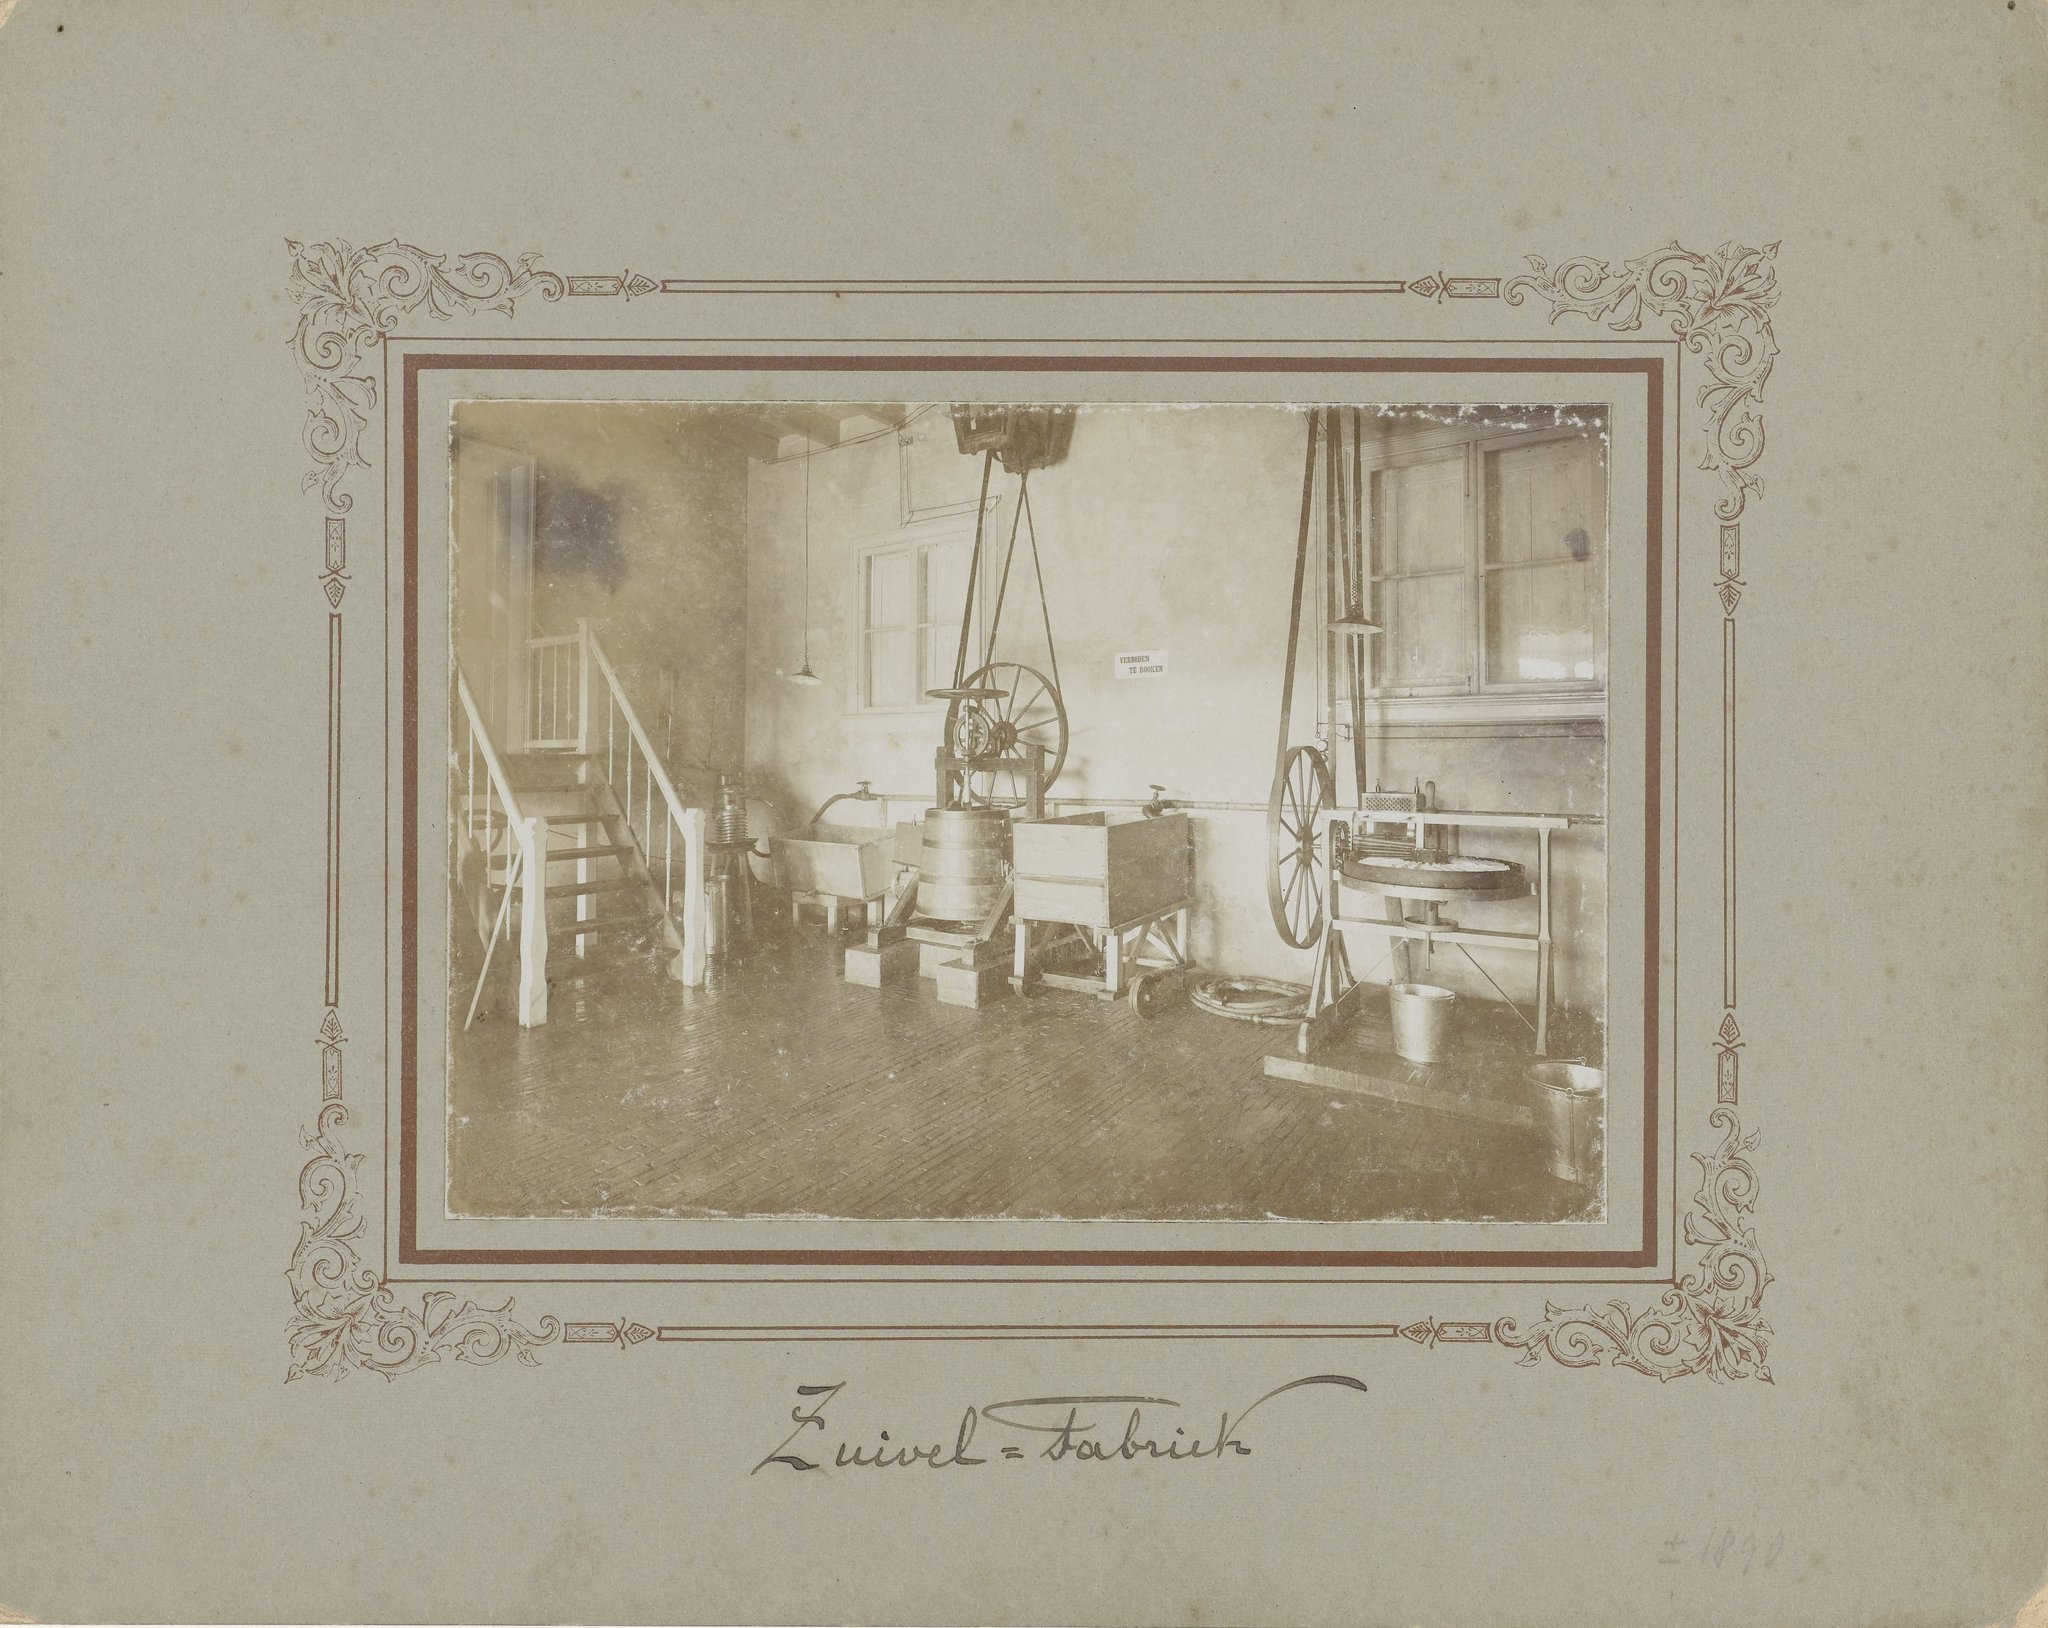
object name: photograph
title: zuivel fabriek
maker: Anonymous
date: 1890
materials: cardboard, photographic support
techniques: albumen print